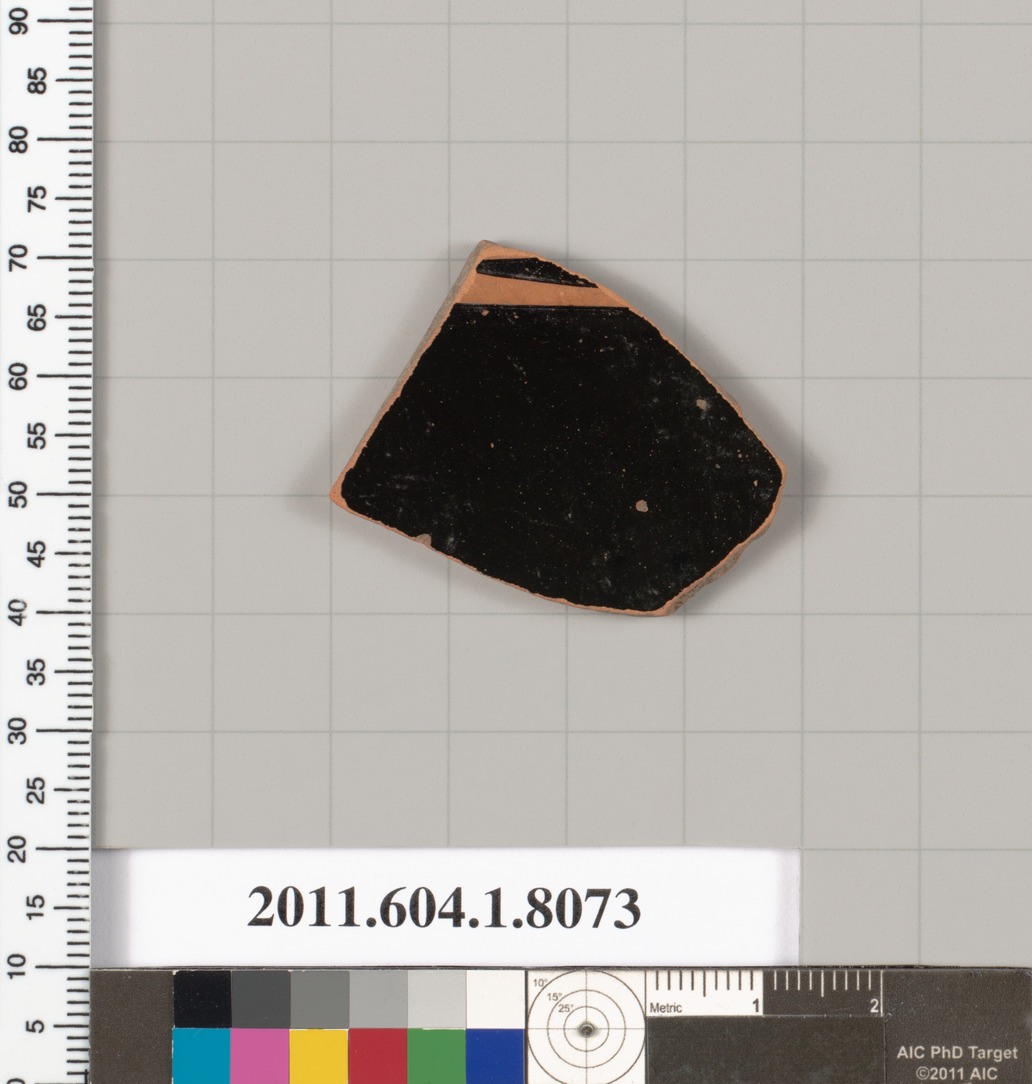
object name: kylix fragment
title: Terracotta fragment of a kylix (drinking cup)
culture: greek, attic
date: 510-500 BCE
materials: terracotta